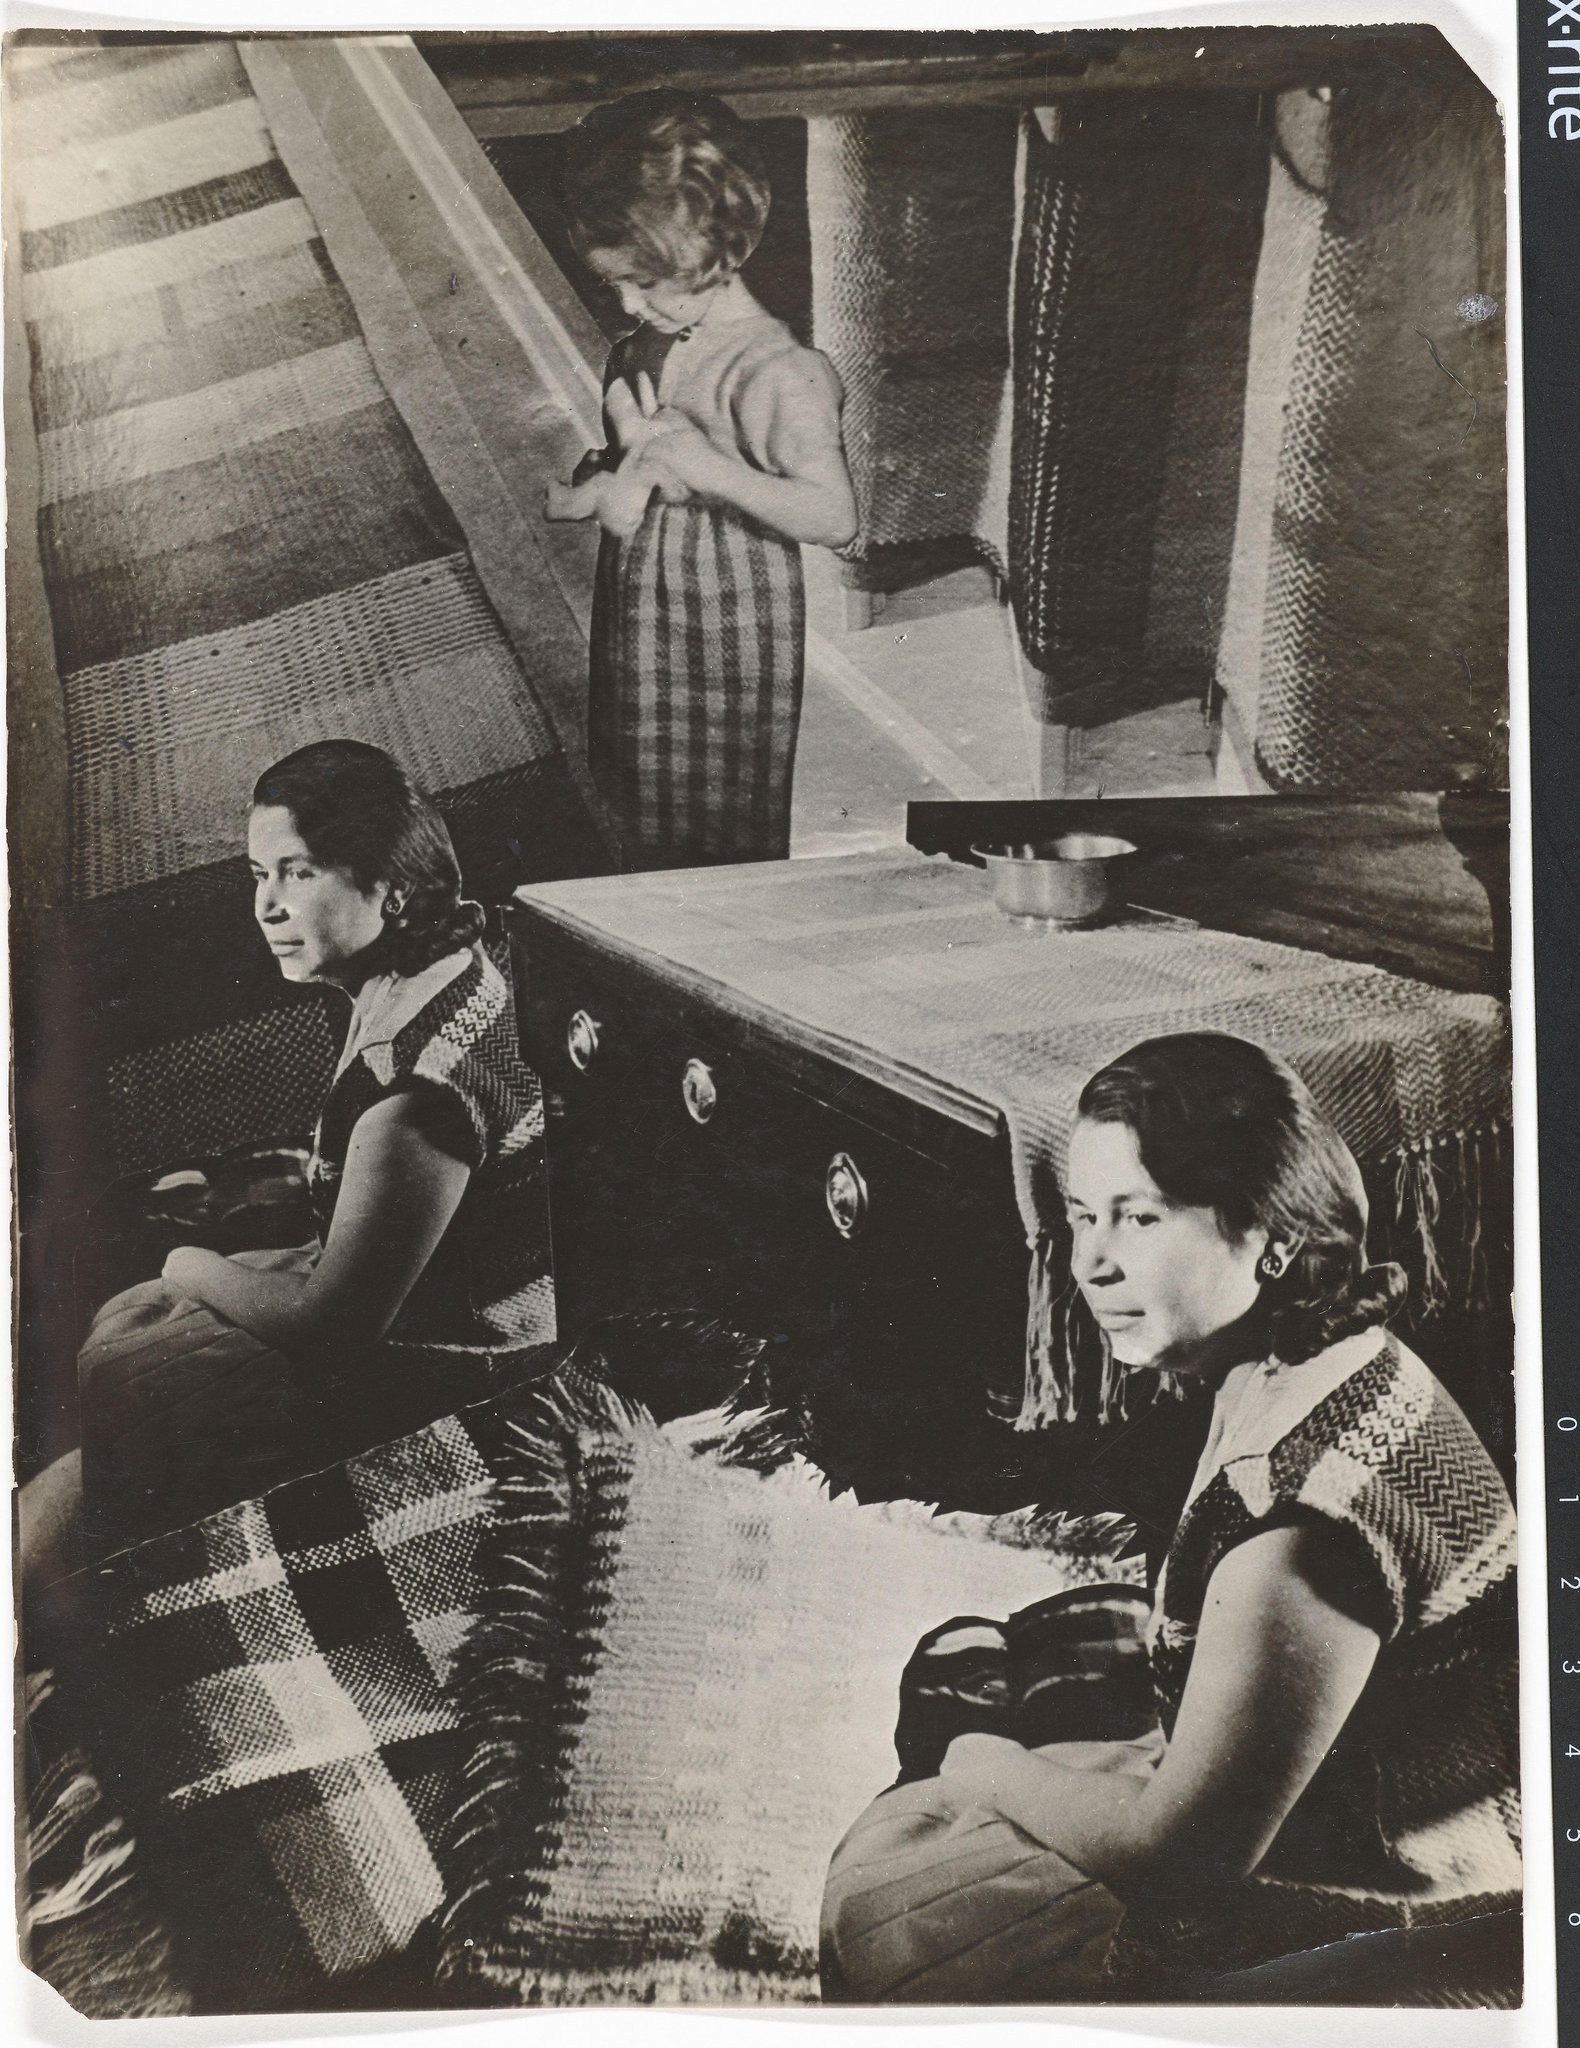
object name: photograph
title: Fotomontage van Erna Kaehler en Jet van Gelder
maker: kurt kahle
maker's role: fotograaf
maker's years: 1897-1953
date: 1935-1940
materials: paper, photographic support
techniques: gelatin silver print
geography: amsterdam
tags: historical persons (portraits and scenes from the life) - bb - woman, textile fabric, cloth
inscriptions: stamp: ‘Kahle / ZUIDER AMSTELLAAN 8 / AMSTERDAM / TEL. 91675’, inscription: ‘copyright:’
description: Fotomontage van een (twee keer voorkomende) vrouw (Erna Kaehler), een meisje (Jet van Gelder), een traploper, twee kussens, een buffetkleed en een vloerkleed.